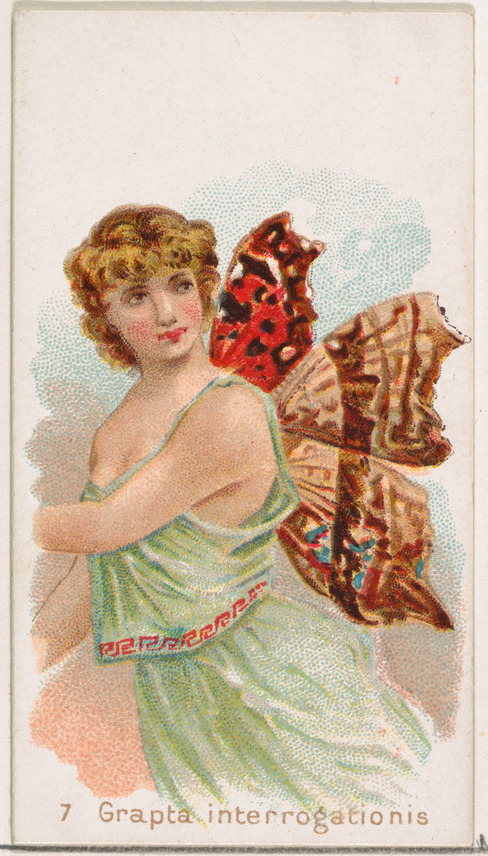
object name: print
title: Card 7, Grapta Interrogationis, from the Butterflies series (N183) issued by Wm. S. Kimball & Co.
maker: william s. kimball & company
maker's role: publisher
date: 1888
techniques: color lithograph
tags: women,butterflies